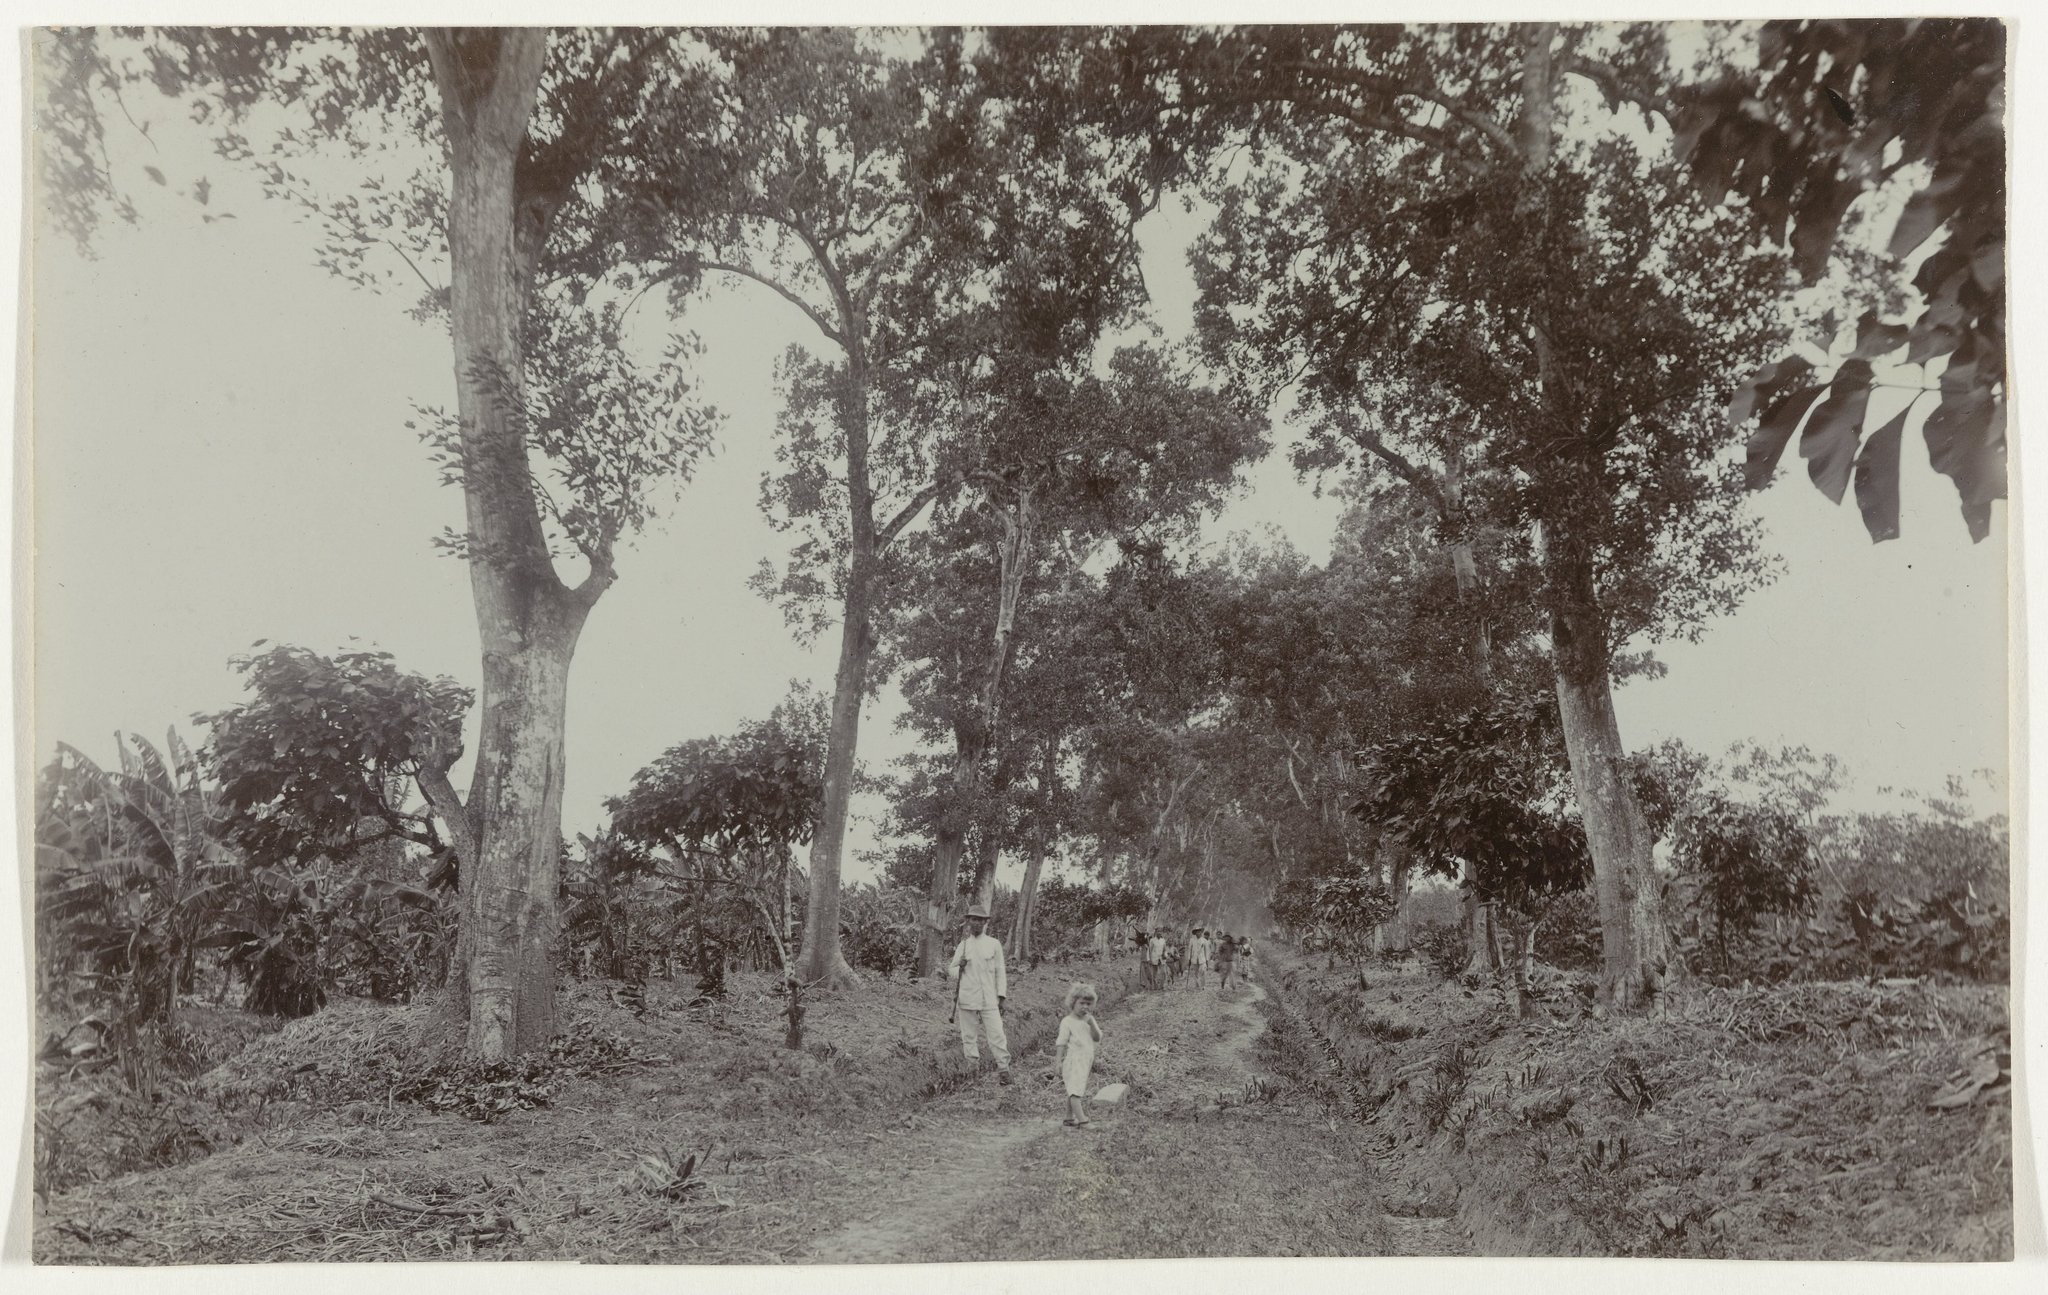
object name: photograph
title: Dora Brouwers in een laan op de plantage Johanna Catherina in Suriname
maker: theodoor brouwers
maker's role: amateurfotograaf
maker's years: 1874-1932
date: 1916-1930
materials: photographic support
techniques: photography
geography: suriname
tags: theodoor brouwers, plantation, suriname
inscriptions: inscription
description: Dora Brouwers in een laan op de plantage Johanna-Catherina in Suriname.